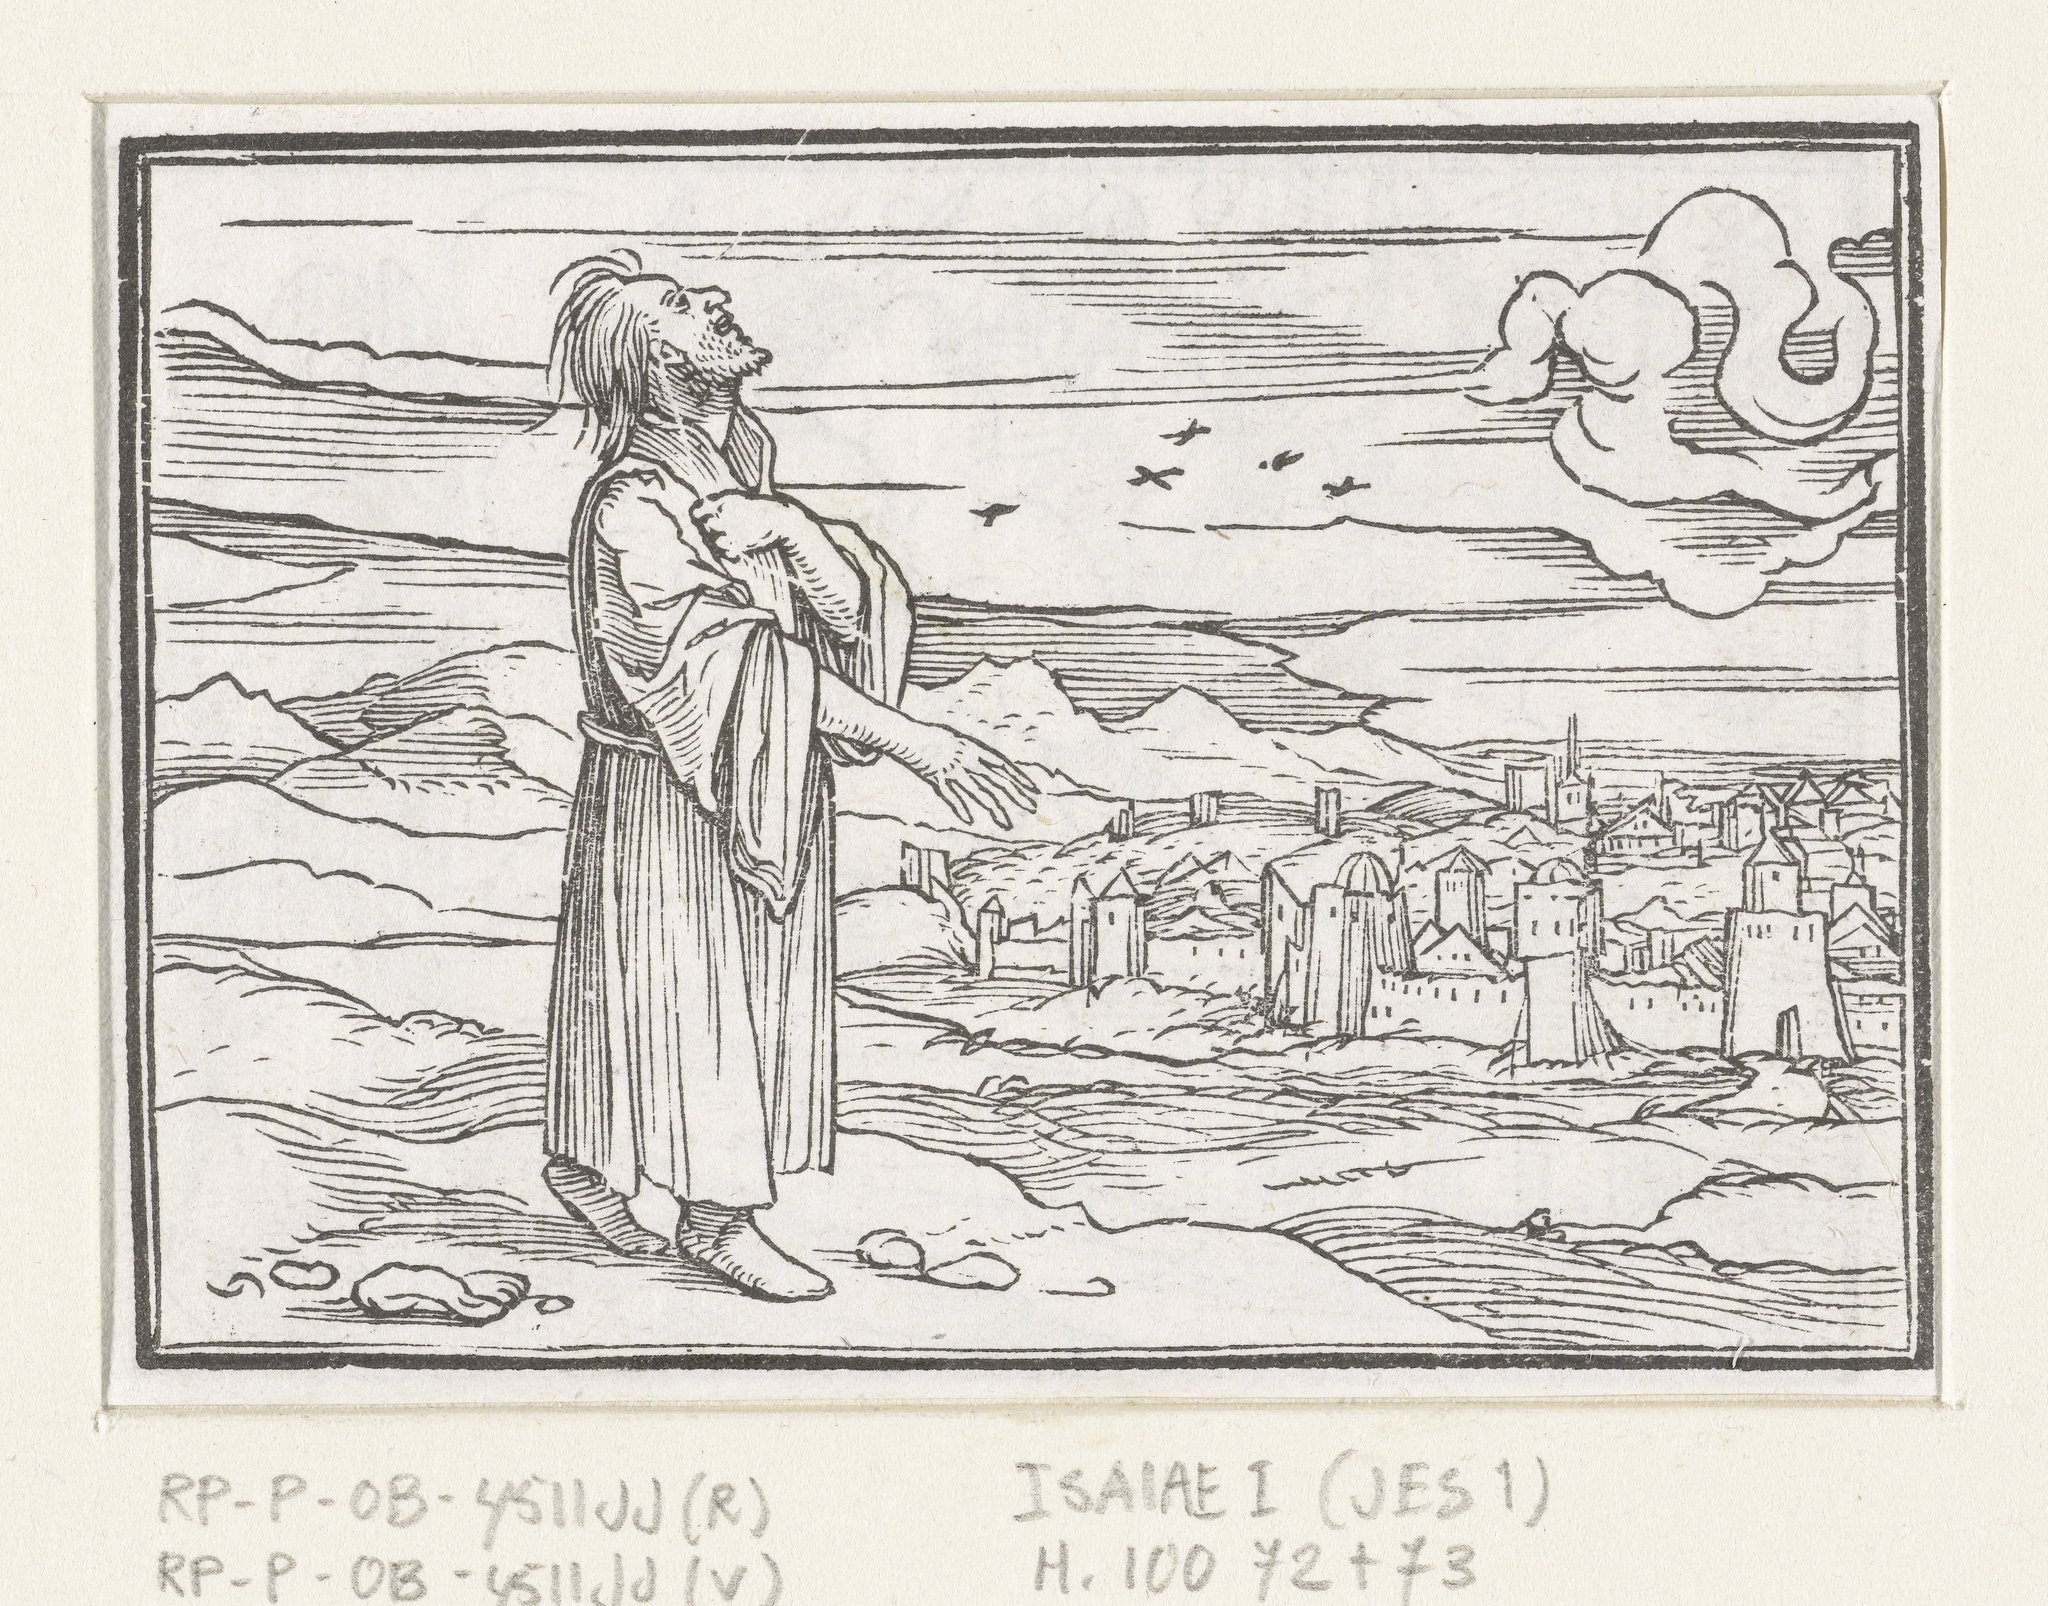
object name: print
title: Jesaja houdt aanklacht tegen Jeruzalem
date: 1538-1543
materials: paper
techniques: woodcut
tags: canticles, lamentations and consolations of isaiah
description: Dit houtblok werd niet gebruikt in de eerste uitgave van Biblia Utriusque Testamenti iuxta Vulgatam Translationem, Lyon, M. en G. Trechsel (voor Hugo à Porta) 1538 maar in een latere druk. Zie Hollstein German 100, nr. 72.